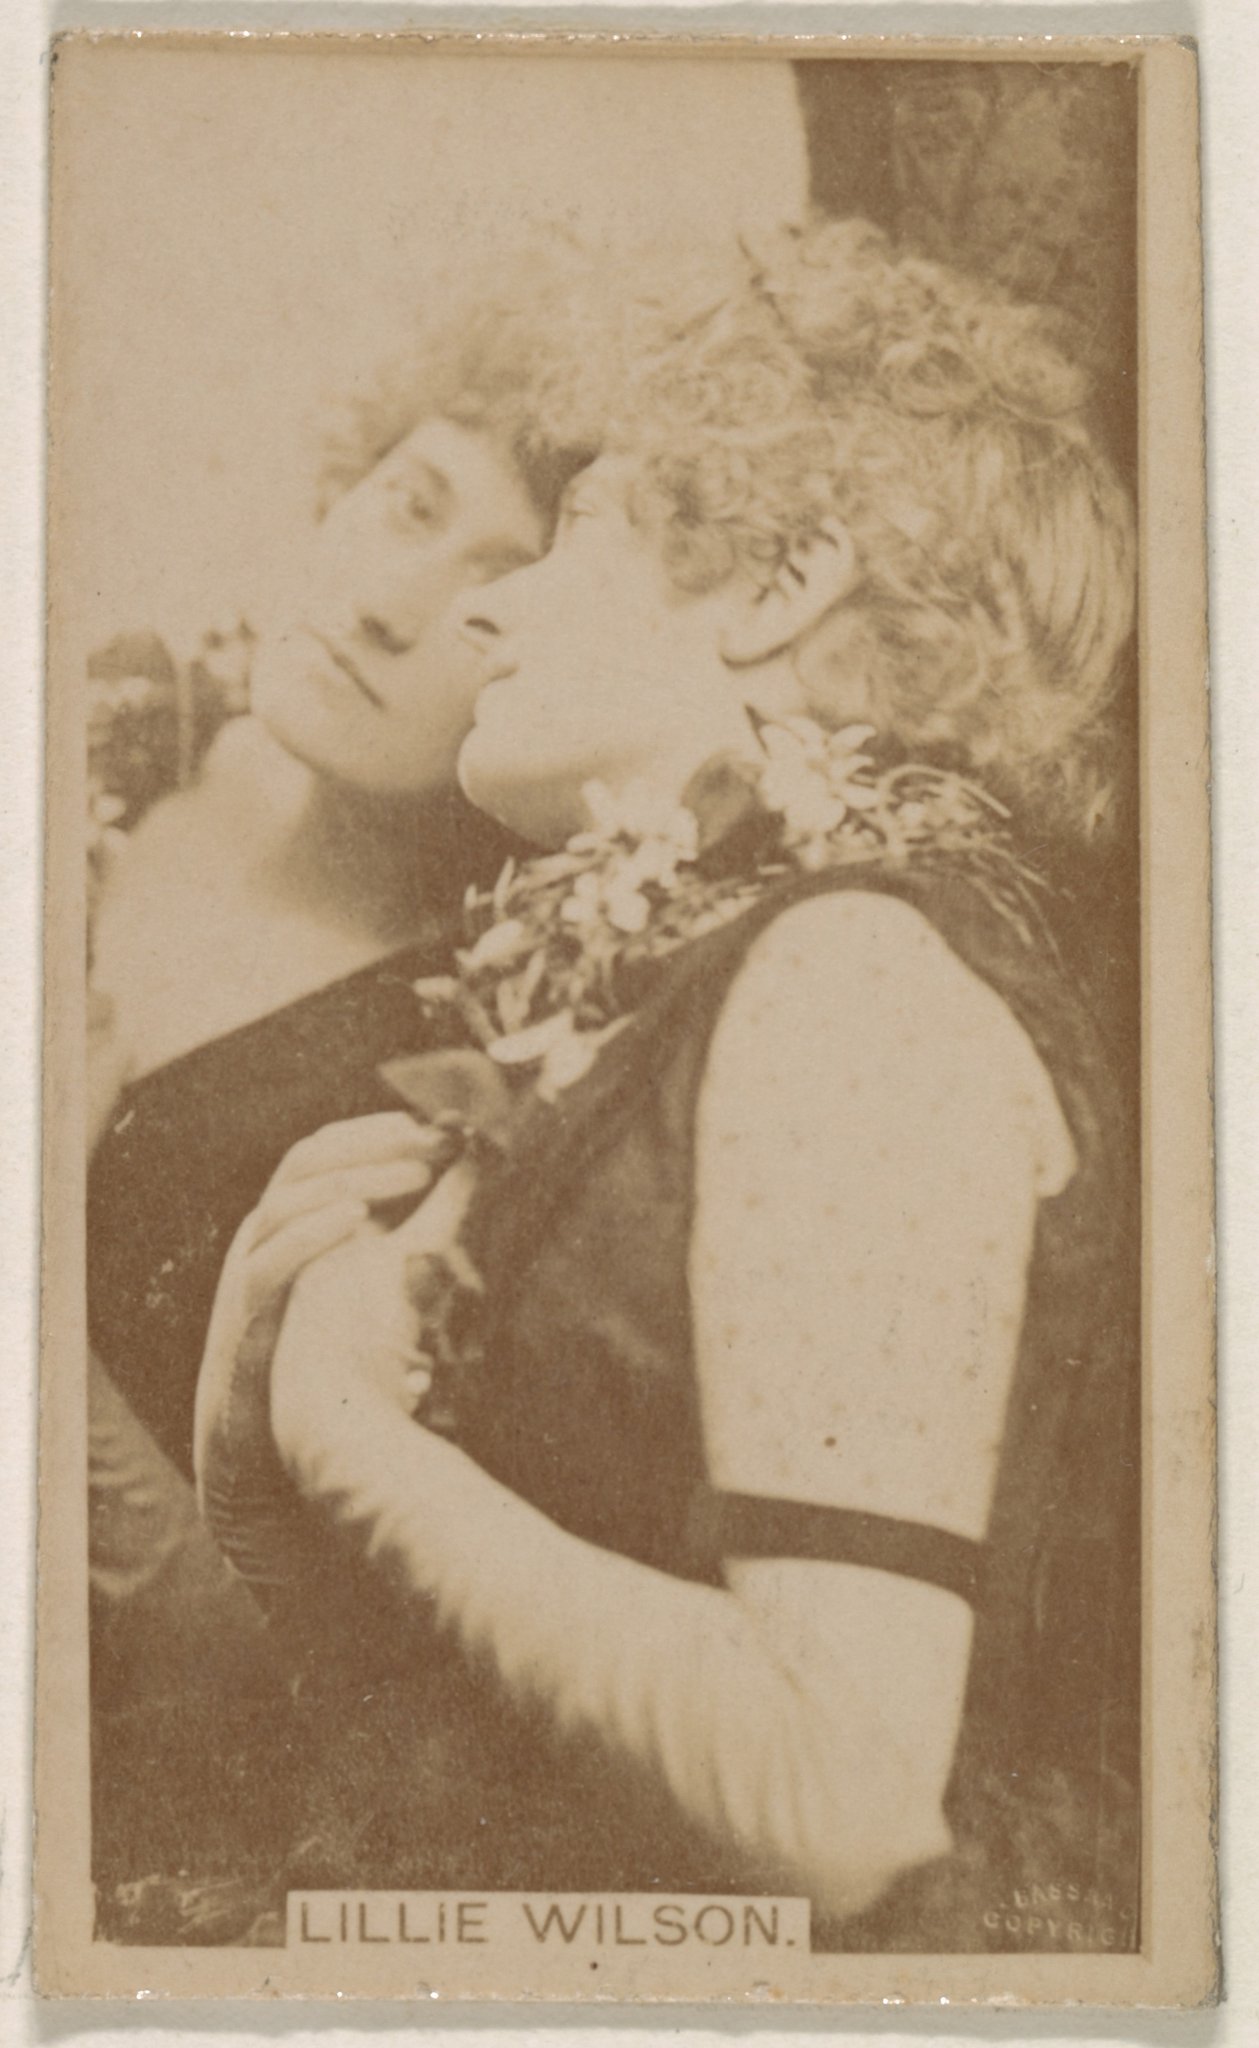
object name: photograph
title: Lillie Wilson, from the Actresses series (N245) issued by Kinney Brothers to promote Sweet Caporal Cigarettes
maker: kinney brothers tobacco company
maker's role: publisher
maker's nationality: american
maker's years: 1869-2011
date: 1890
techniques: albumen silver print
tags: women,actresses